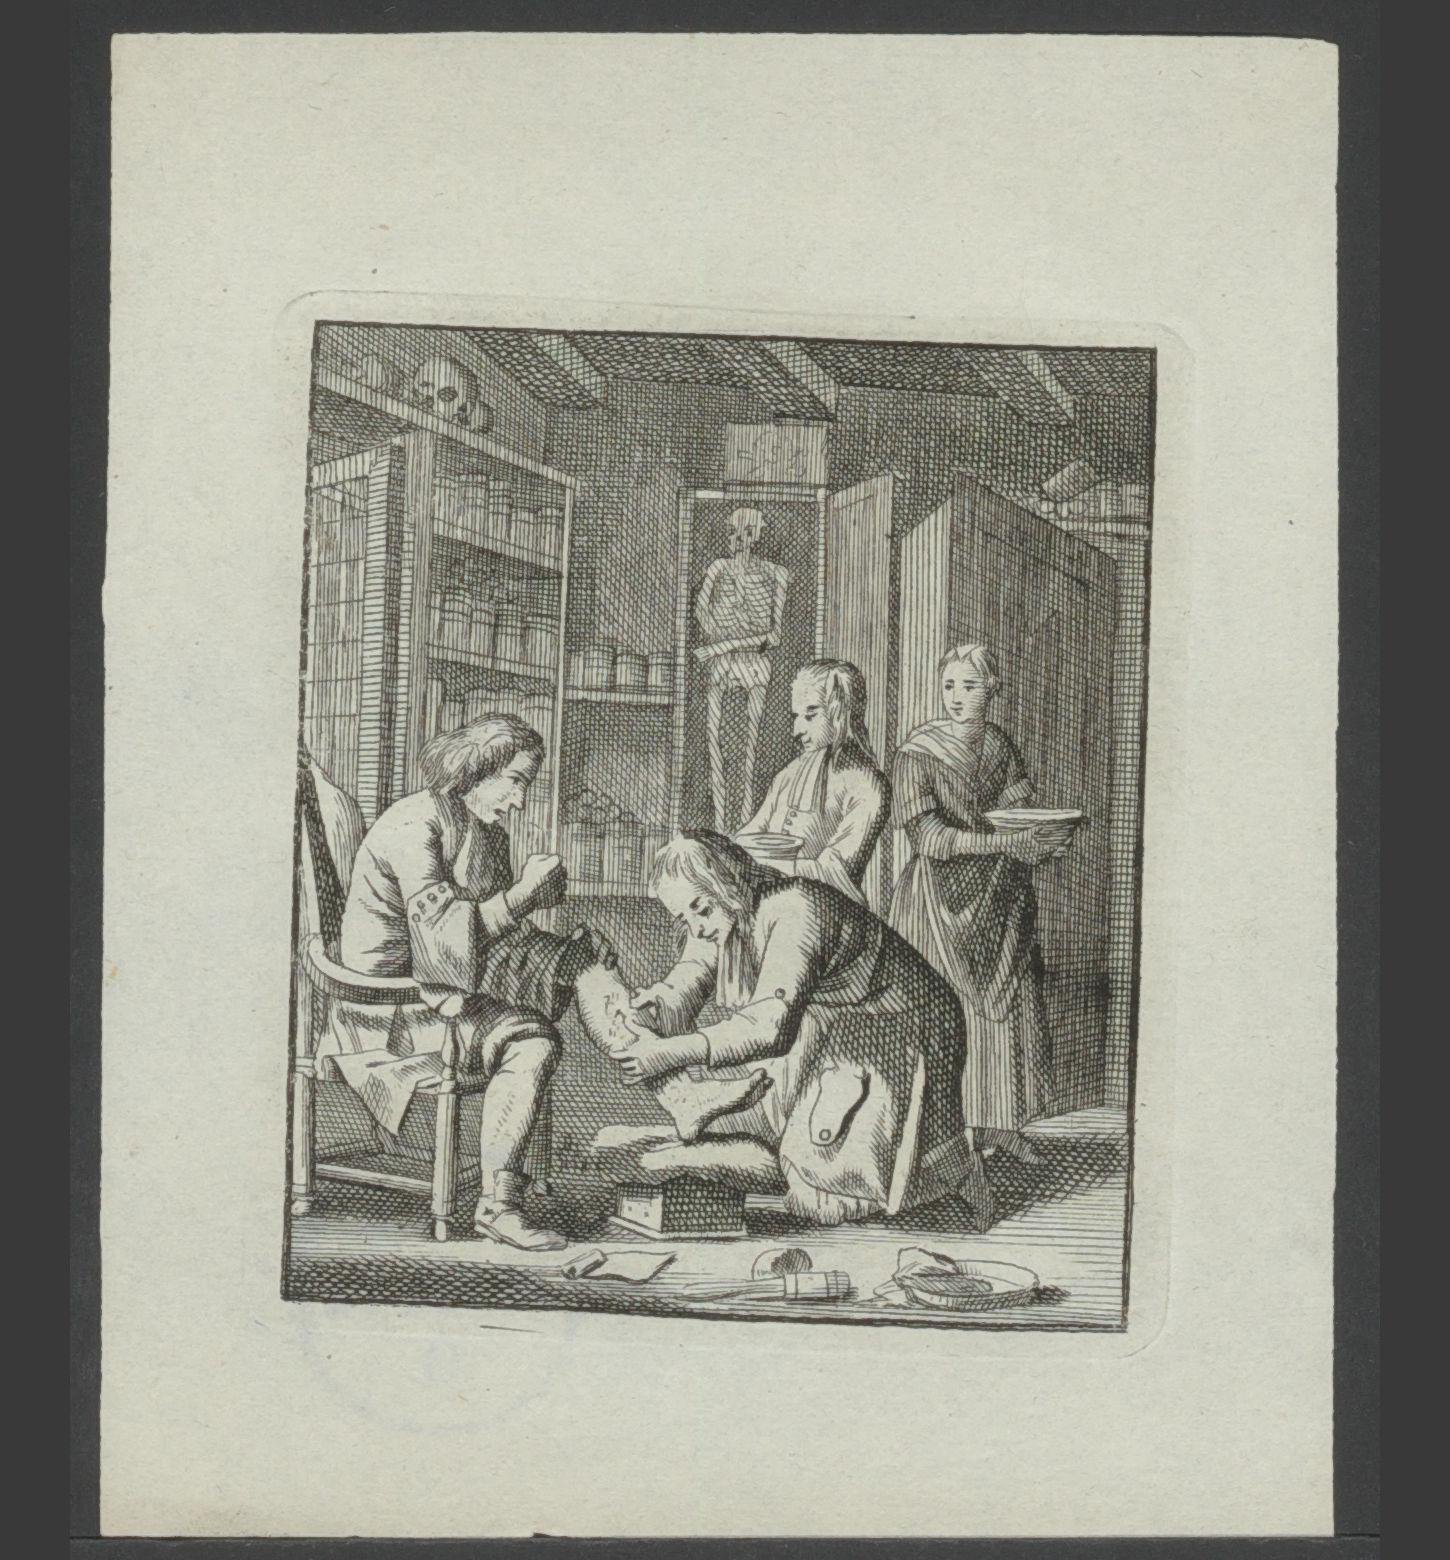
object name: print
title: Chirurgijn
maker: Anonymous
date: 1694-1799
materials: paper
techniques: engraving, etching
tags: flour- and grain-products, handicrafts, craftsman at work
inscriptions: collector's mark: Lugt 1641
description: Onderwerpsrubrieken binnen de Atlas Zeden en Gewoonten: Handel, Nijverheid en Verkeer, Beroep en bedrijf, Complete suites.